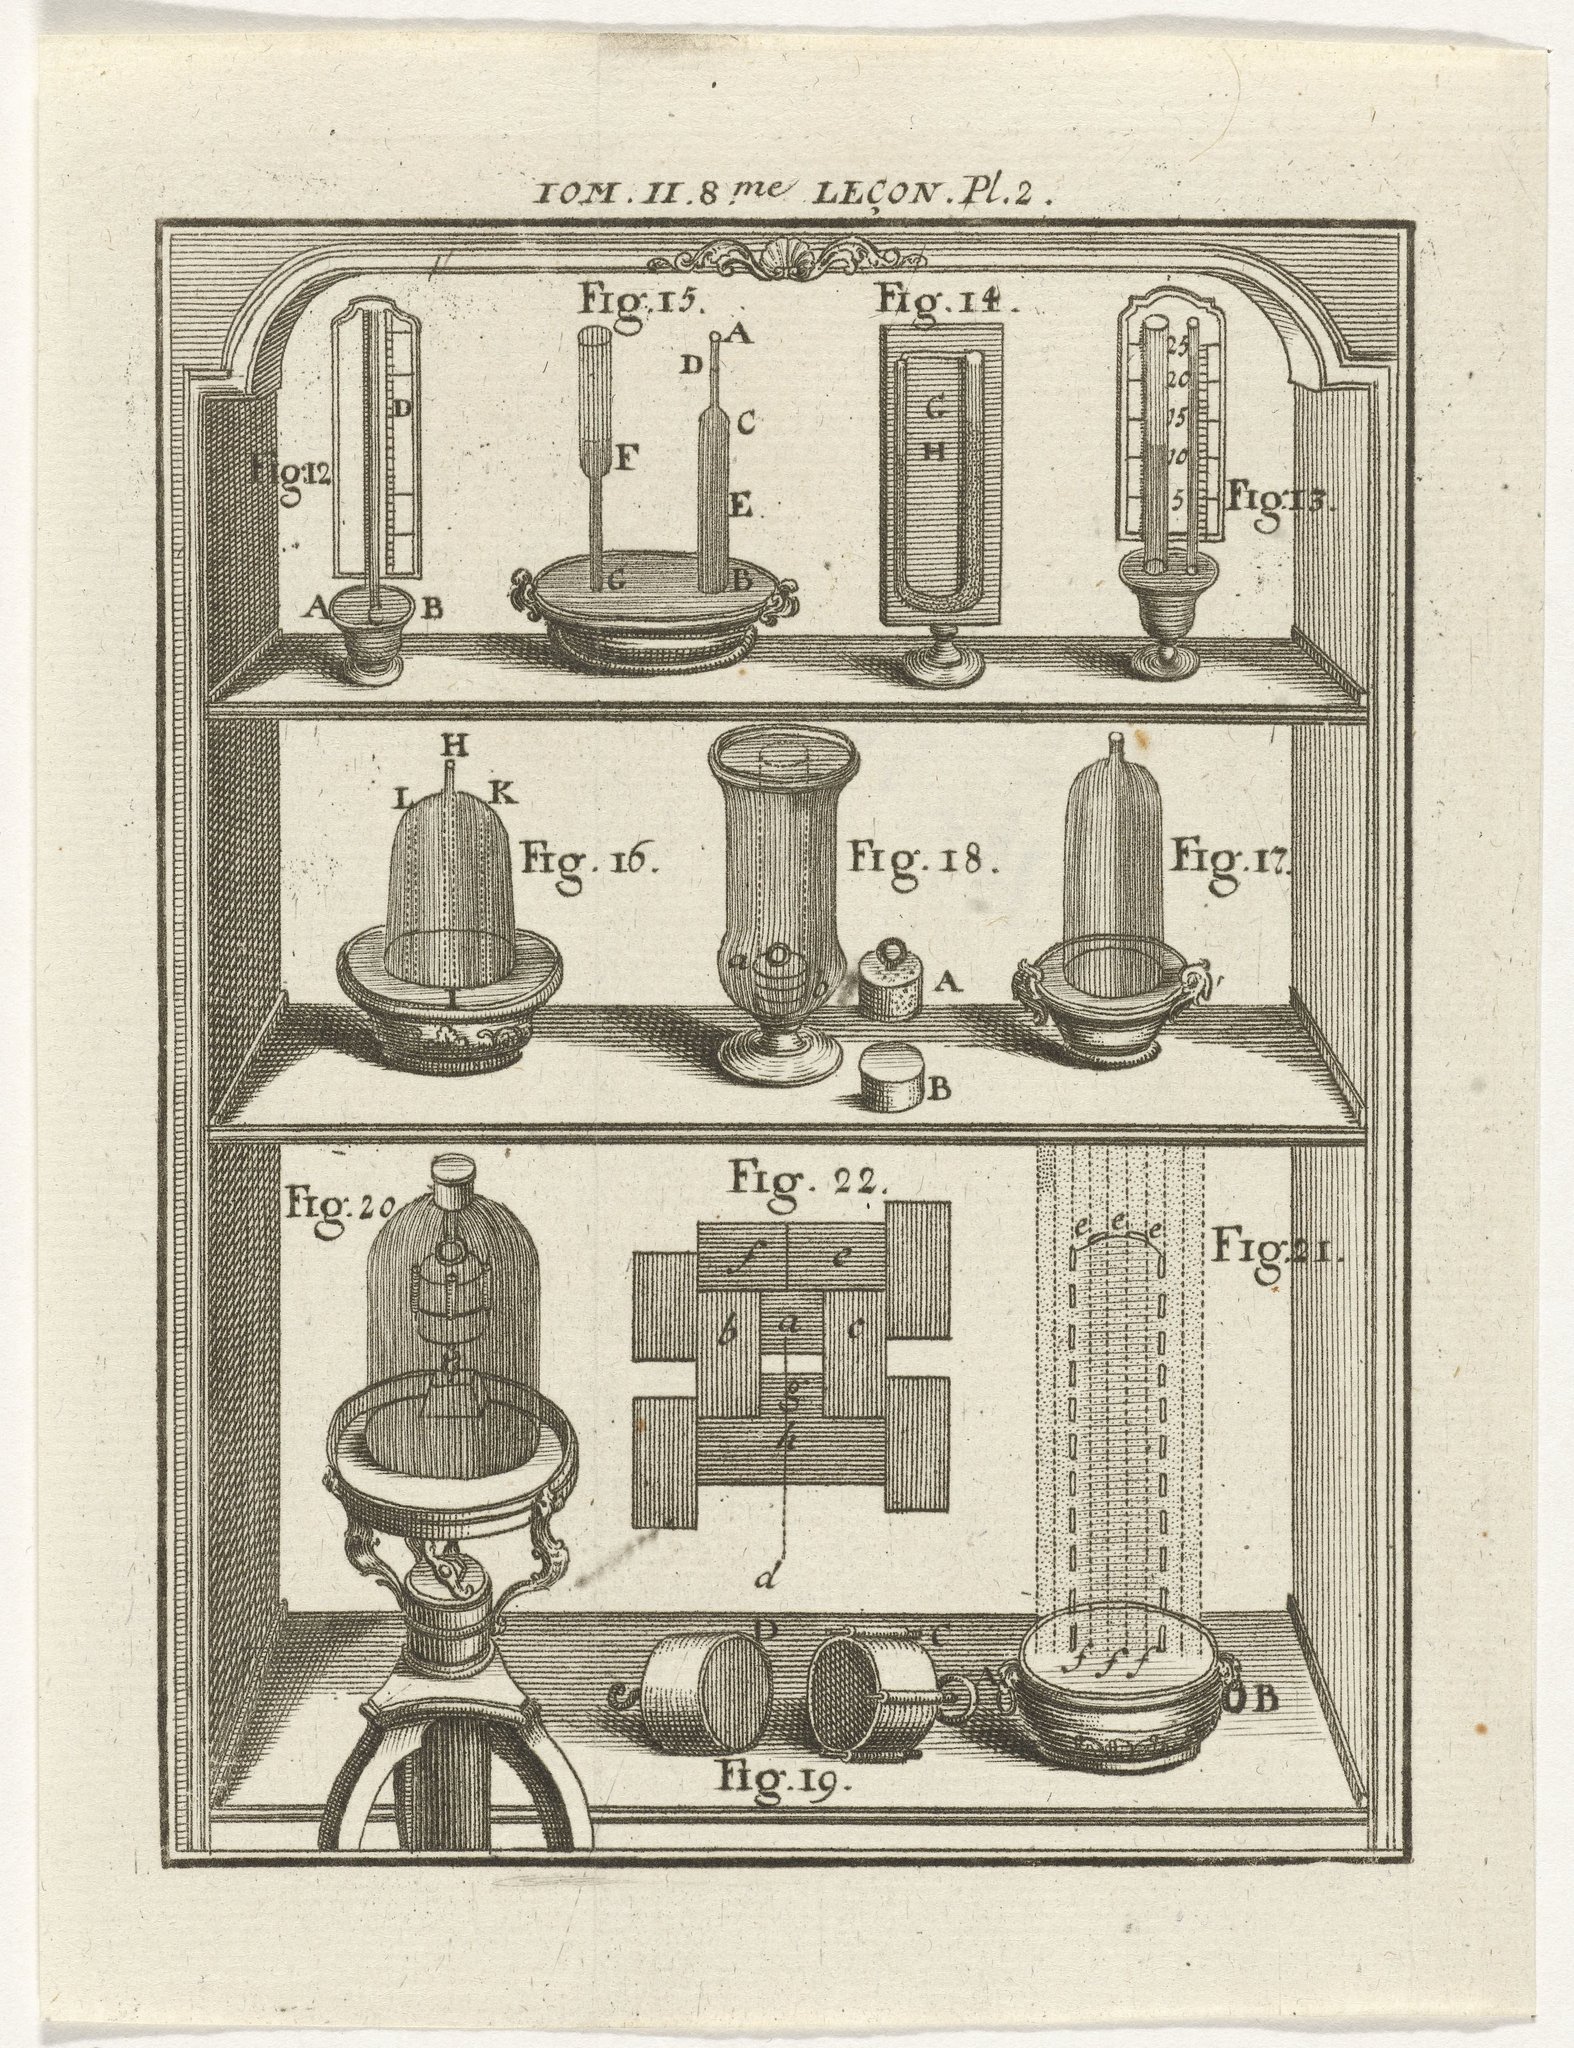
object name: book illustration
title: Natuurkundige instrumenten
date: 1759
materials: paper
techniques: etching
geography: amsterdam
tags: physics (+ tools, instruments; laboratory equipment ~ scientific research)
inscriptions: collector's mark: Lugt 2228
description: Illustratie voor: Nollet, Jean Antoine. Natuurkundige lessen, door proefneemingen bevestigd, eerste deel. Amsterdam: Kornelis van Tongerlo, 1759.